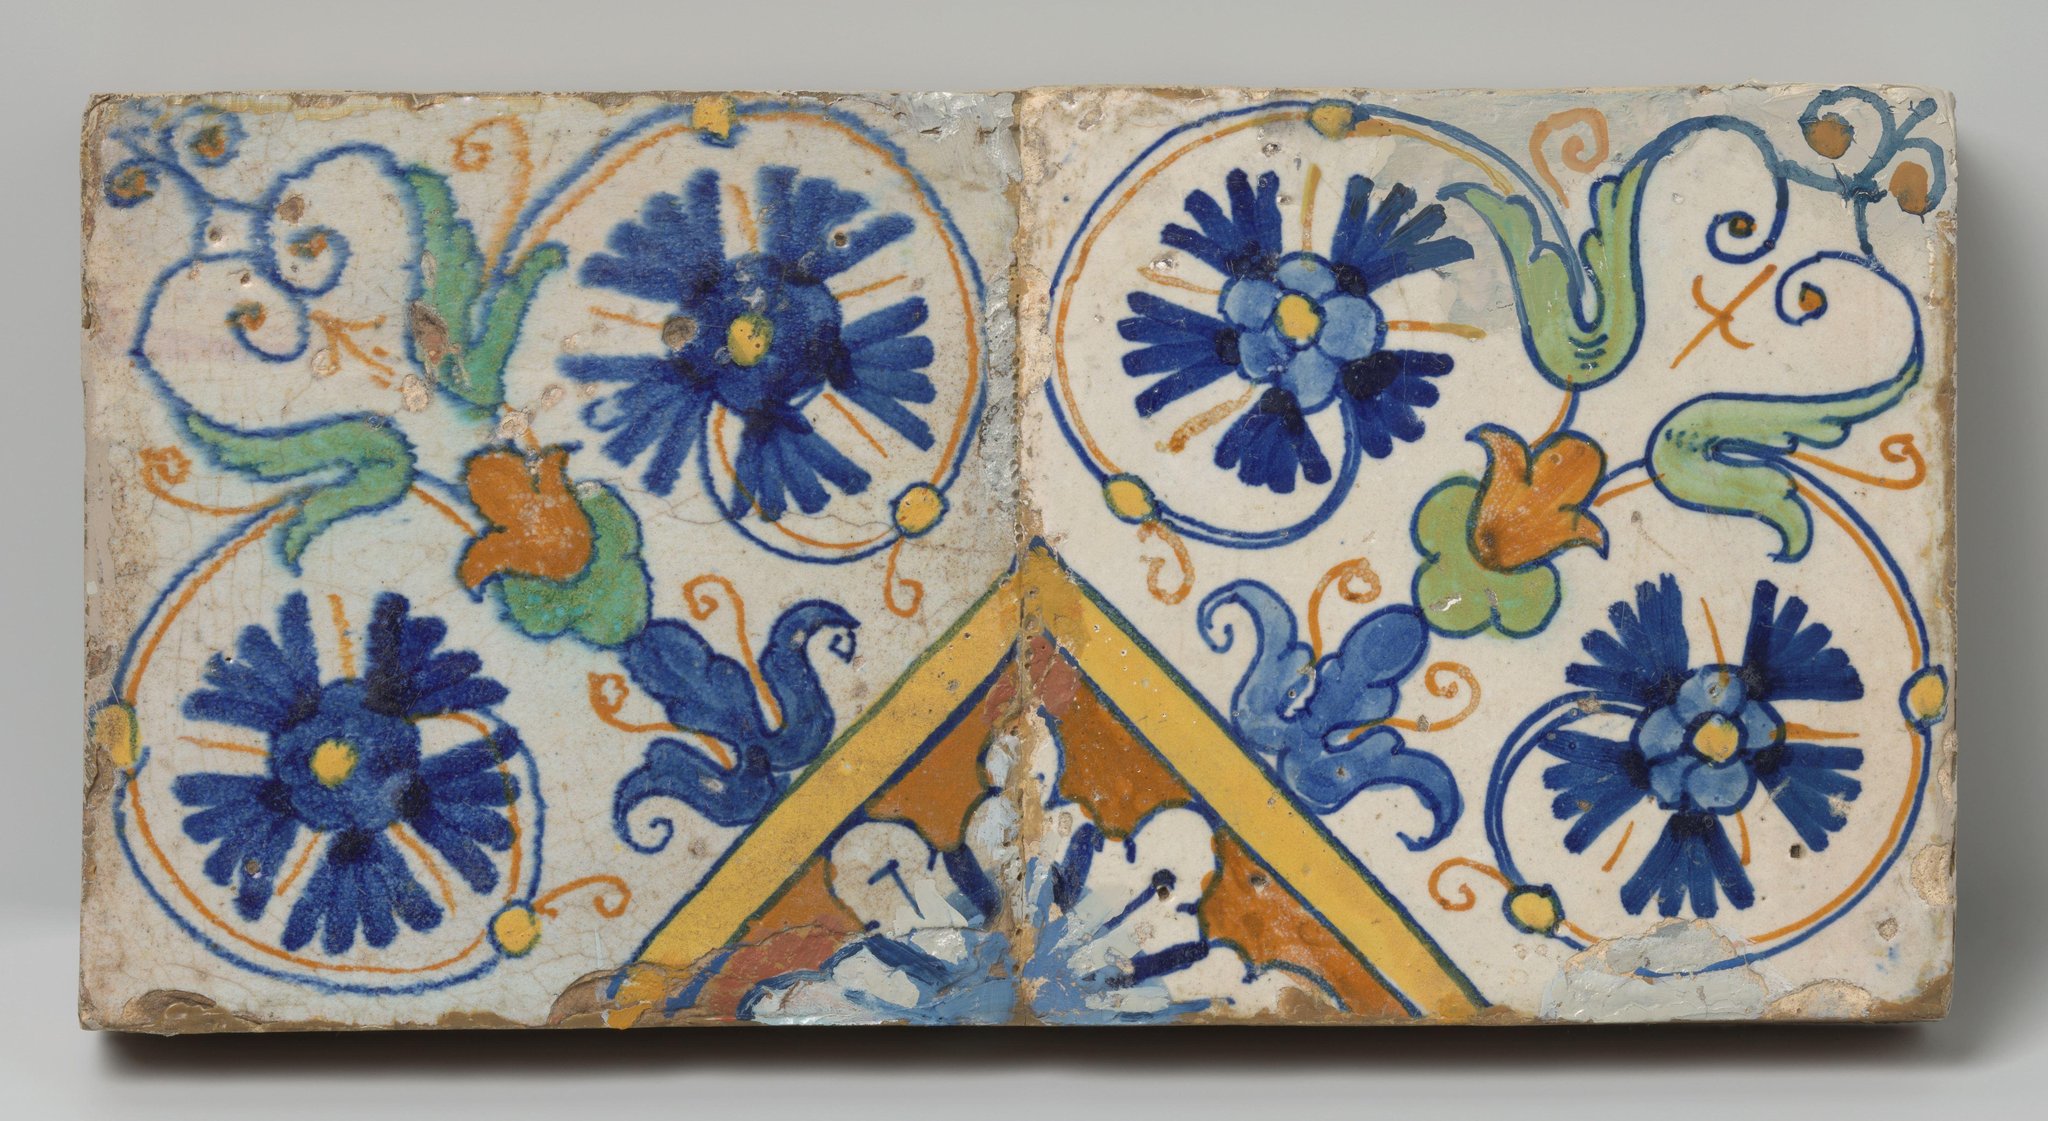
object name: tegelveld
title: Veld van twee tegels met rozetten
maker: Anonymous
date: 1610-1630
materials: earthenware, glaze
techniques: maiolica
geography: netherlands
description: Veld van twee tegels (1 x 2) elk met een veelkleurig (blauw, groen, geel en oranje) ornament van rozetten en ranken. In één van de vier hoeken, een kwart van een kwadraat.